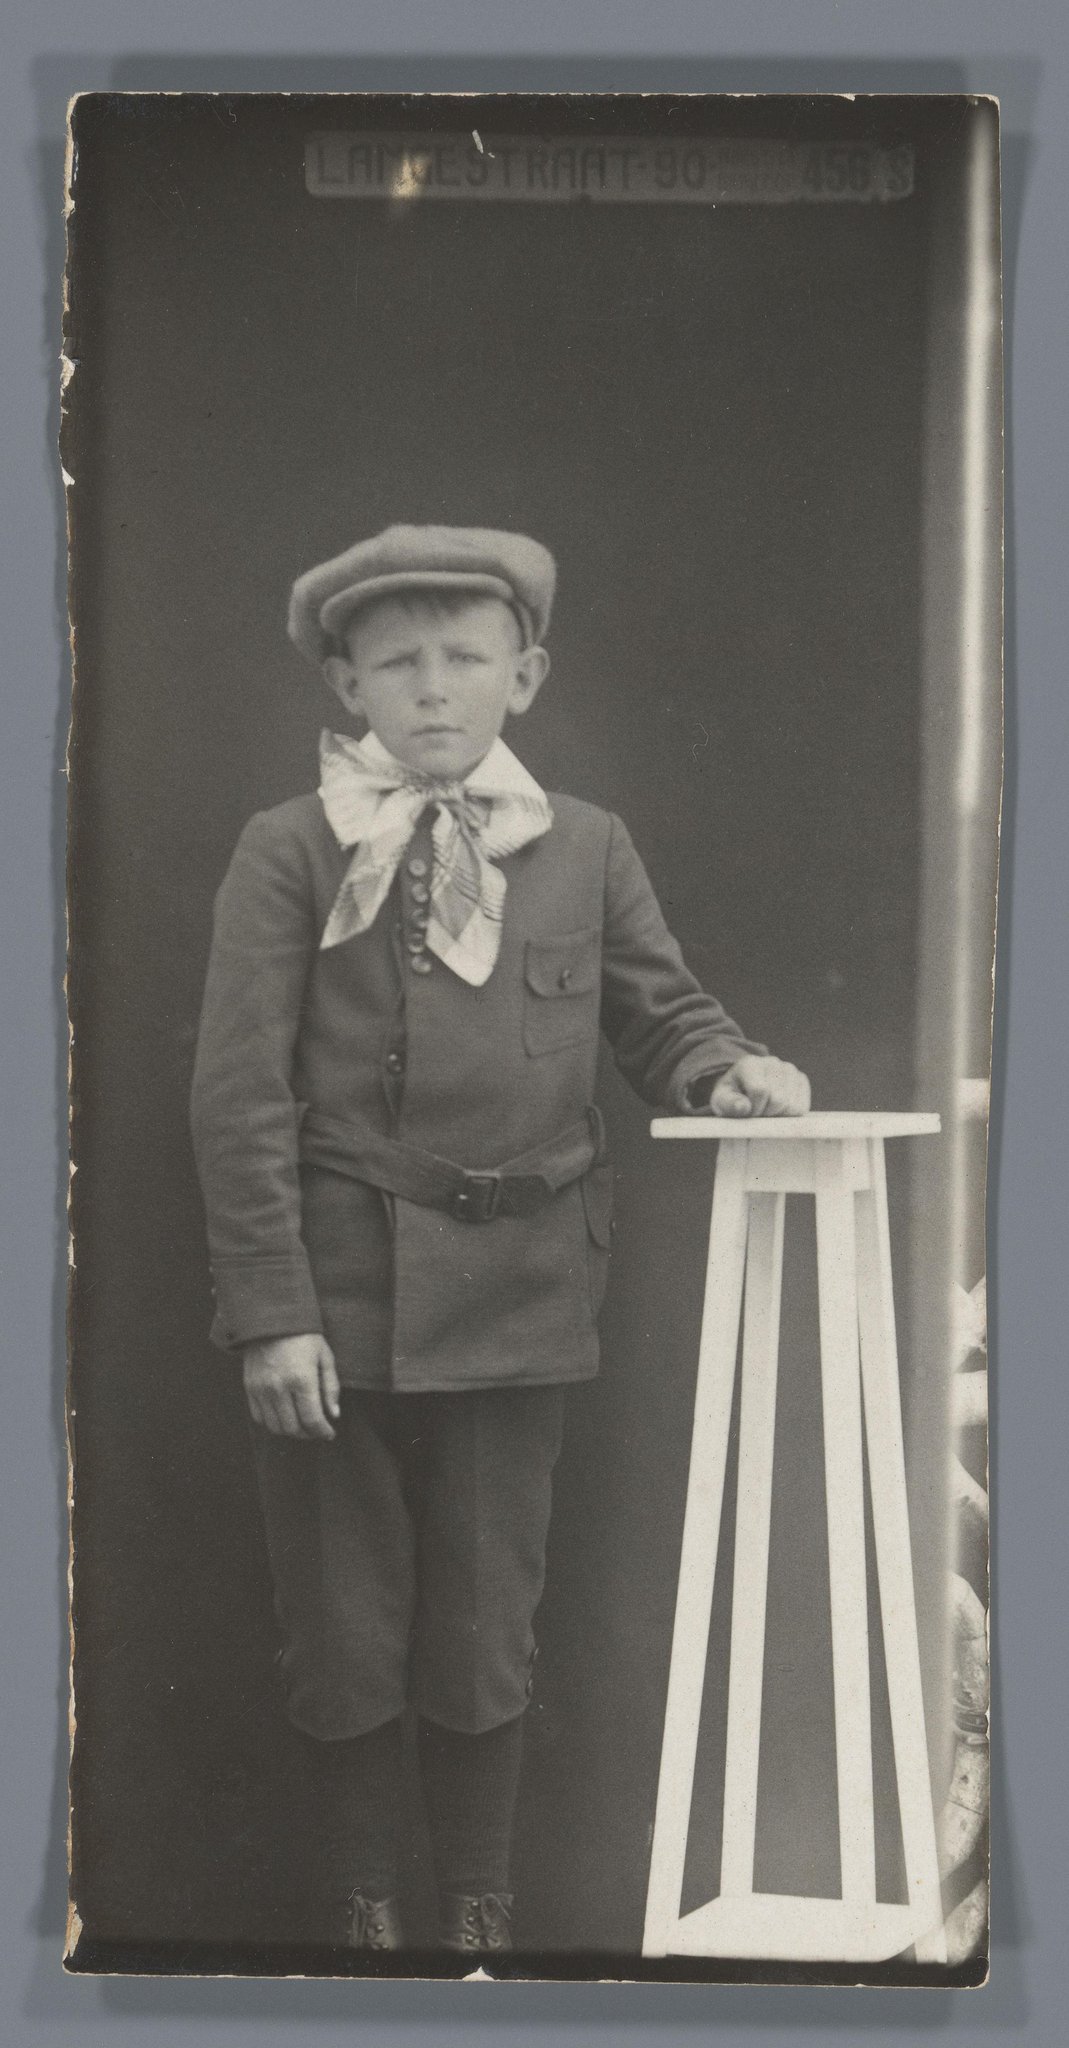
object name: snapshot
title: Rapid photographs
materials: photographic support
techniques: gelatin silver print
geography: alkmaar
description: Between 1912 and 1930, anyone could have their portrait taken at the many so-called rapid photography studios in the shopping streets of mainly (medium) large-size European cities. As if on an assembly line, the youngest clerk shot the photographs with a special camera and in artificial light and developed them. Later in the day, the customer collected a sheet with 12 portrait photos for 25 cents. This form of photographic mass production gave rise to a fascinating tableau of boys, girls, men and women not previously seen in photographs; candid and informal. There were at least 150 quick-photo studios, from Alkmaar to Zutphen. Many called themselves ‘American,’ mistakenly as it turns out because hardly any examples from that country have been found.